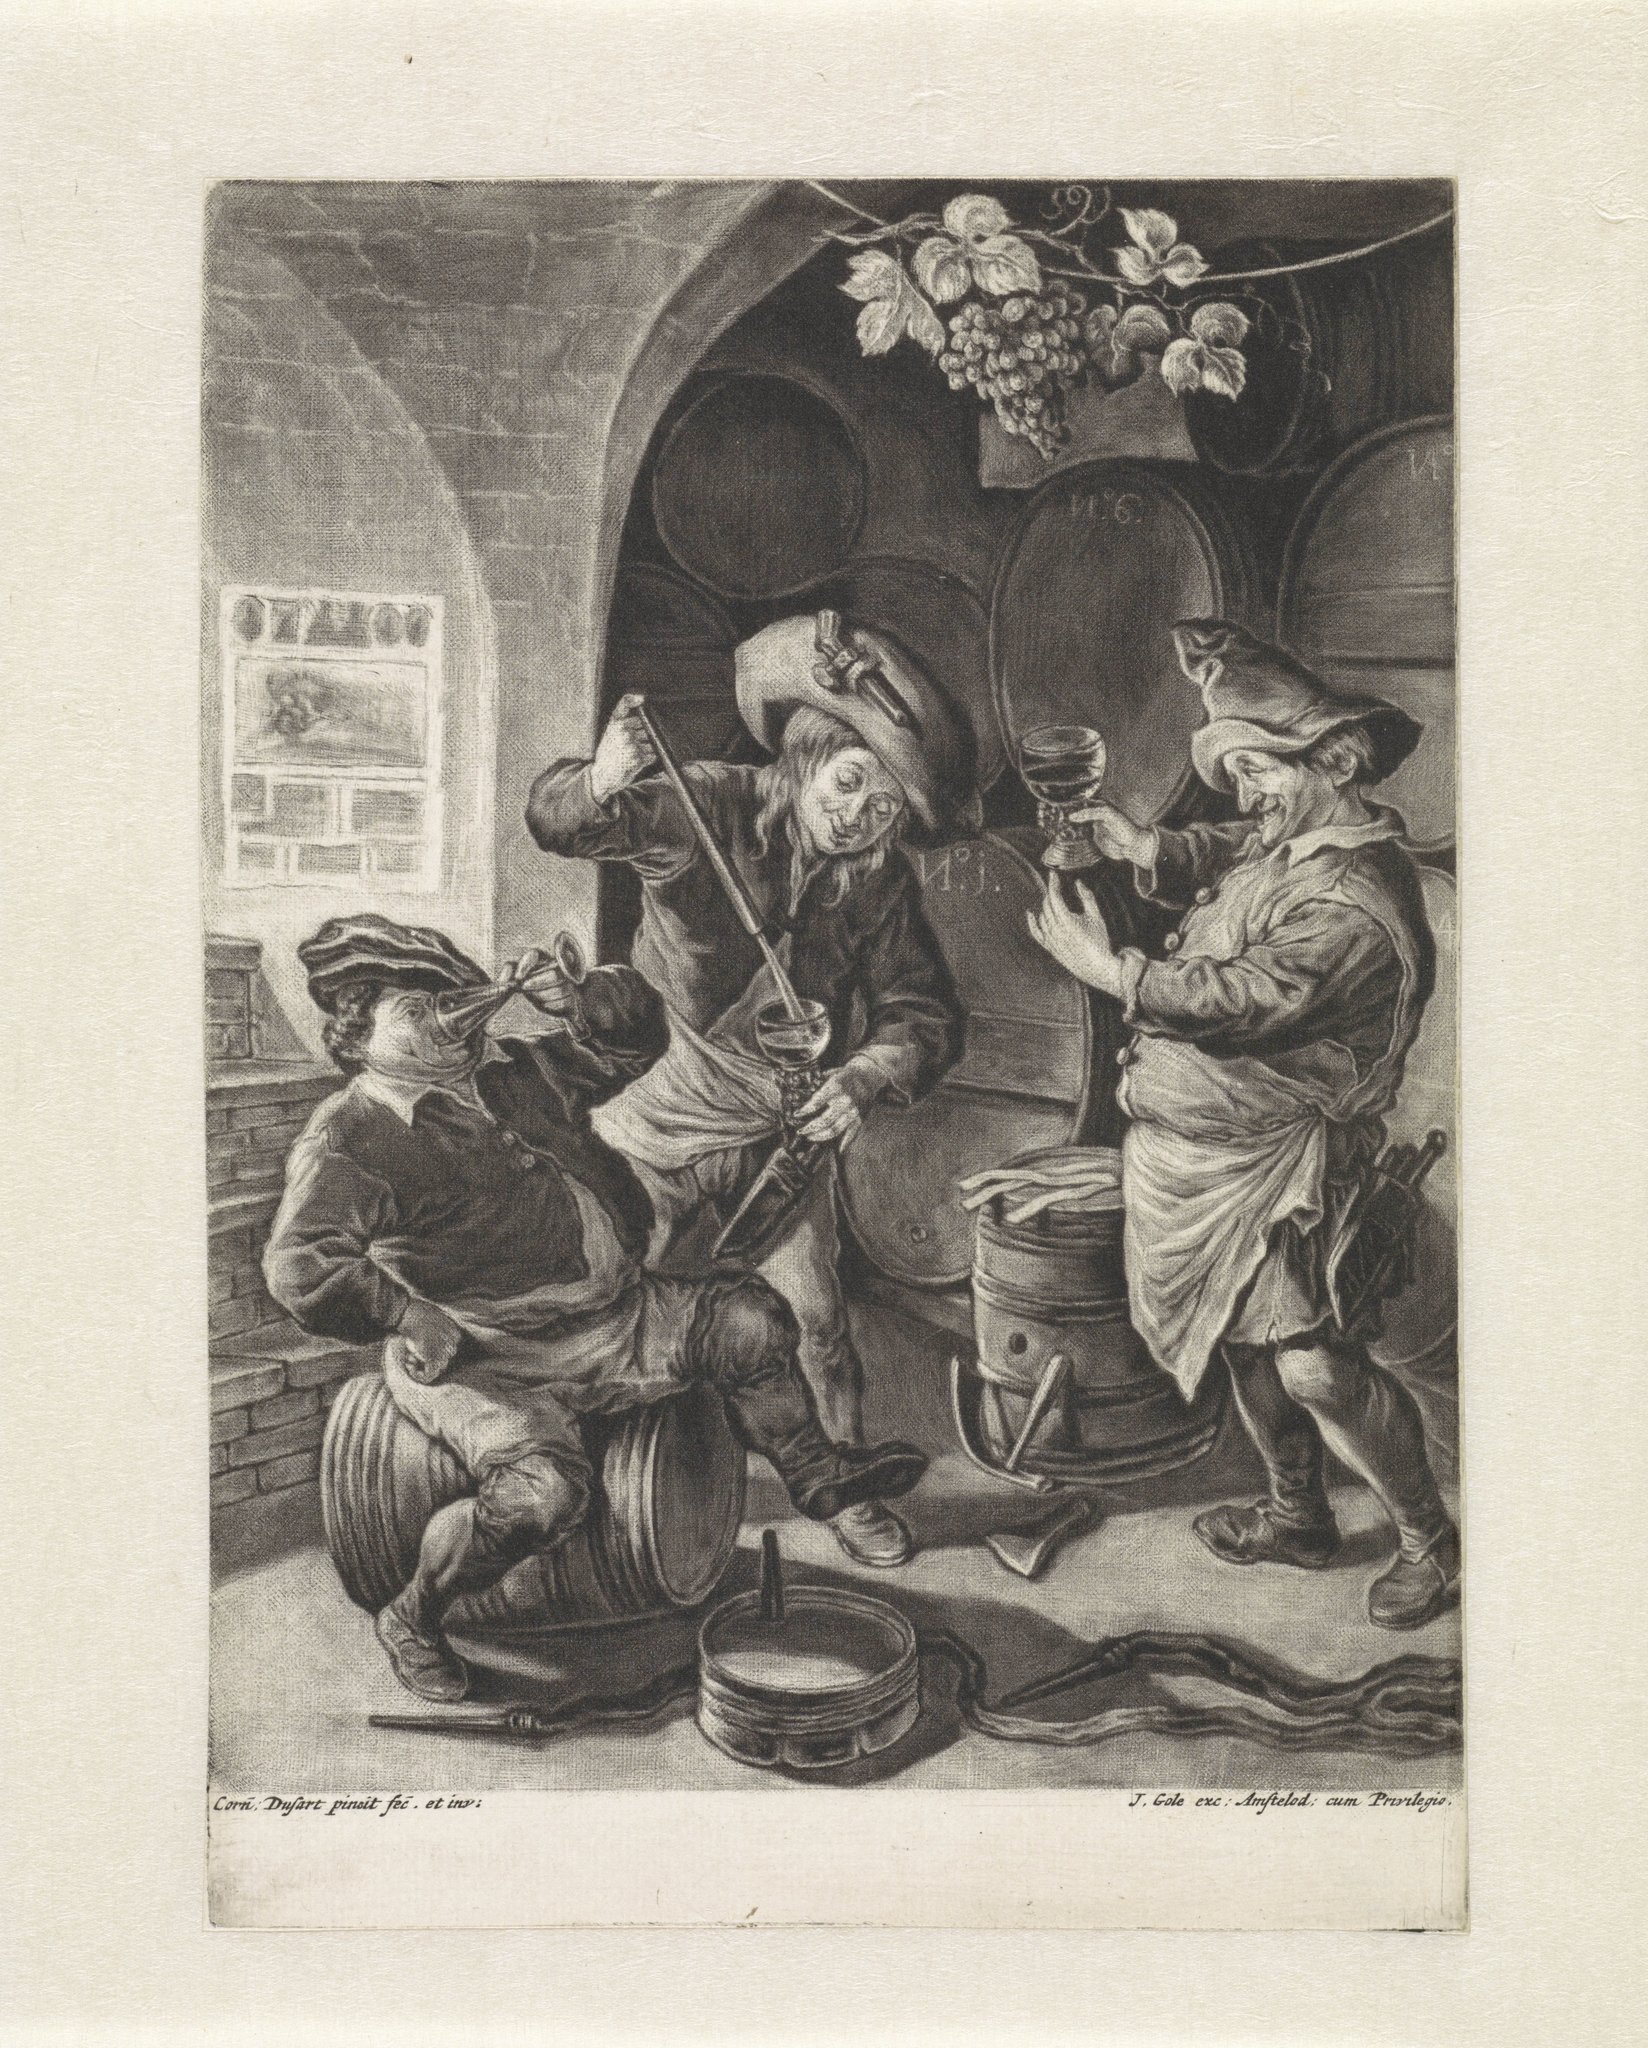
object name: print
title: Oktober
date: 1679-1704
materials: paper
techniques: engraving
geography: haarlem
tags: october and its 'labours', wine-testing, wine-grading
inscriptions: collector's mark: Lugt 240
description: Drie mannen proeven wijn. Een van hen neemt een slok, de ander vult zijn roemer en de derde kijkt in zijn glas. Op de achtergrond liggen wijntonnen opgestapeld. De prent maakt deel uit van een serie van twaalf prenten met de twaalf maanden van het jaar.